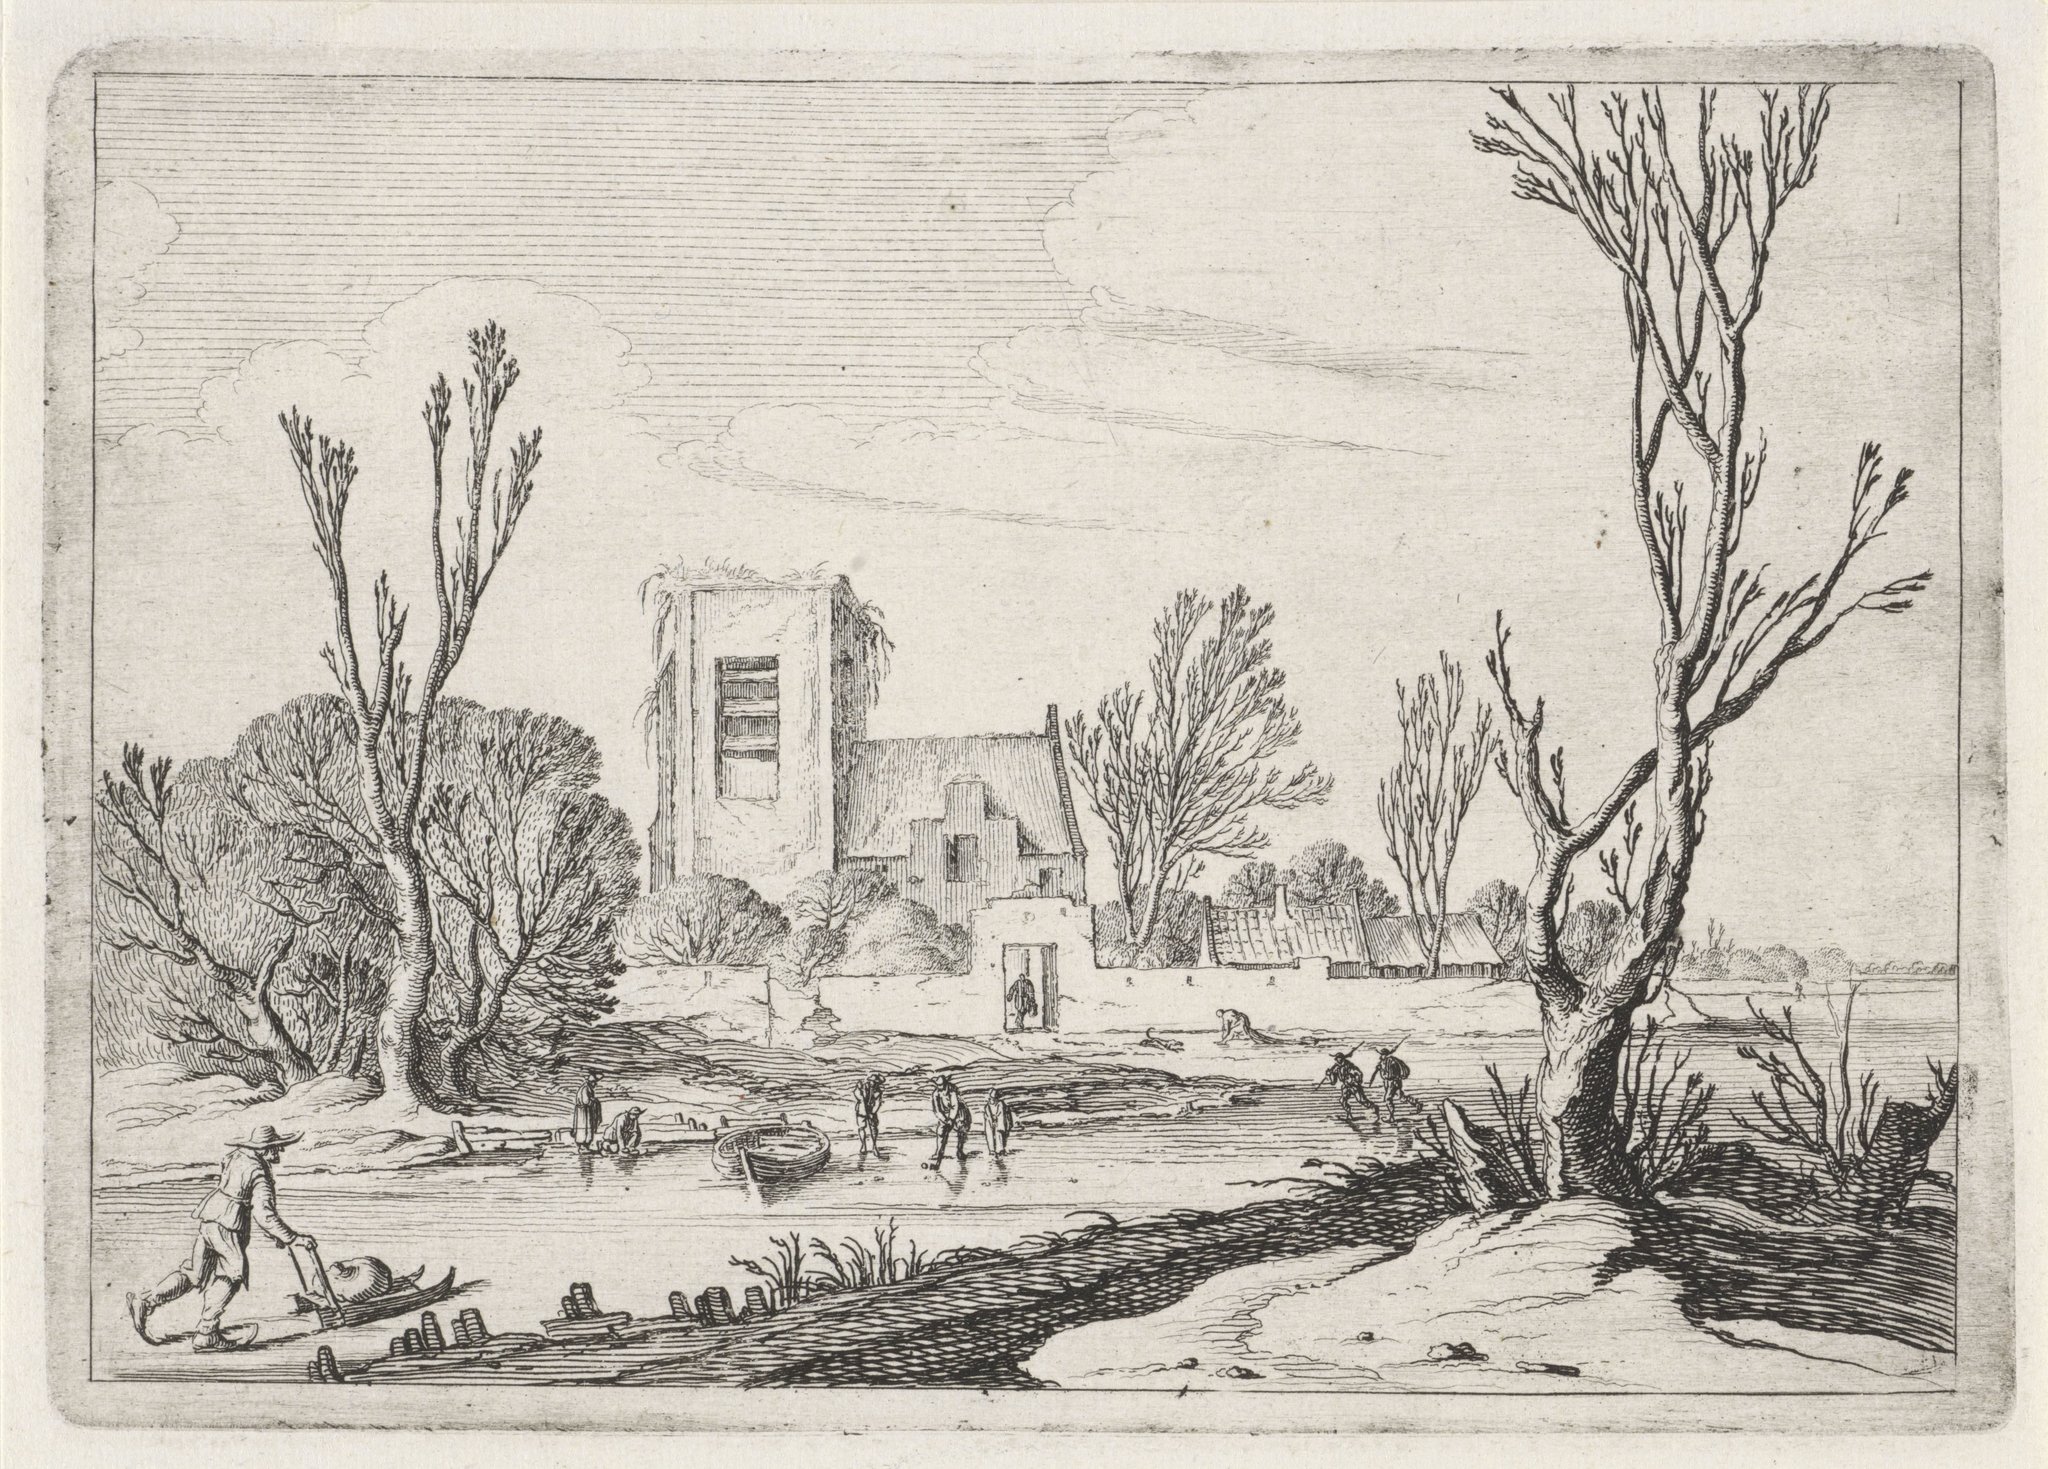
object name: print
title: Zeven landschappen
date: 1631-1656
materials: paper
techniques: etching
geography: amsterdam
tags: church (exterior), winter landscape; landscape symbolizing winter (the four seasons of the year), skates (winter sports), 'kolf' on the ice, sledge, sleigh (winter sports)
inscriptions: collector's mark: Lugt 240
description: IJsvermaak op een bevroren rivier. Op de rivier bevinden zich vissers, kolf spelende heren en schaatsers. Verderop ligt een vastgevroren schip. Op de achtergrond een dorp en een kerk zonder dak.